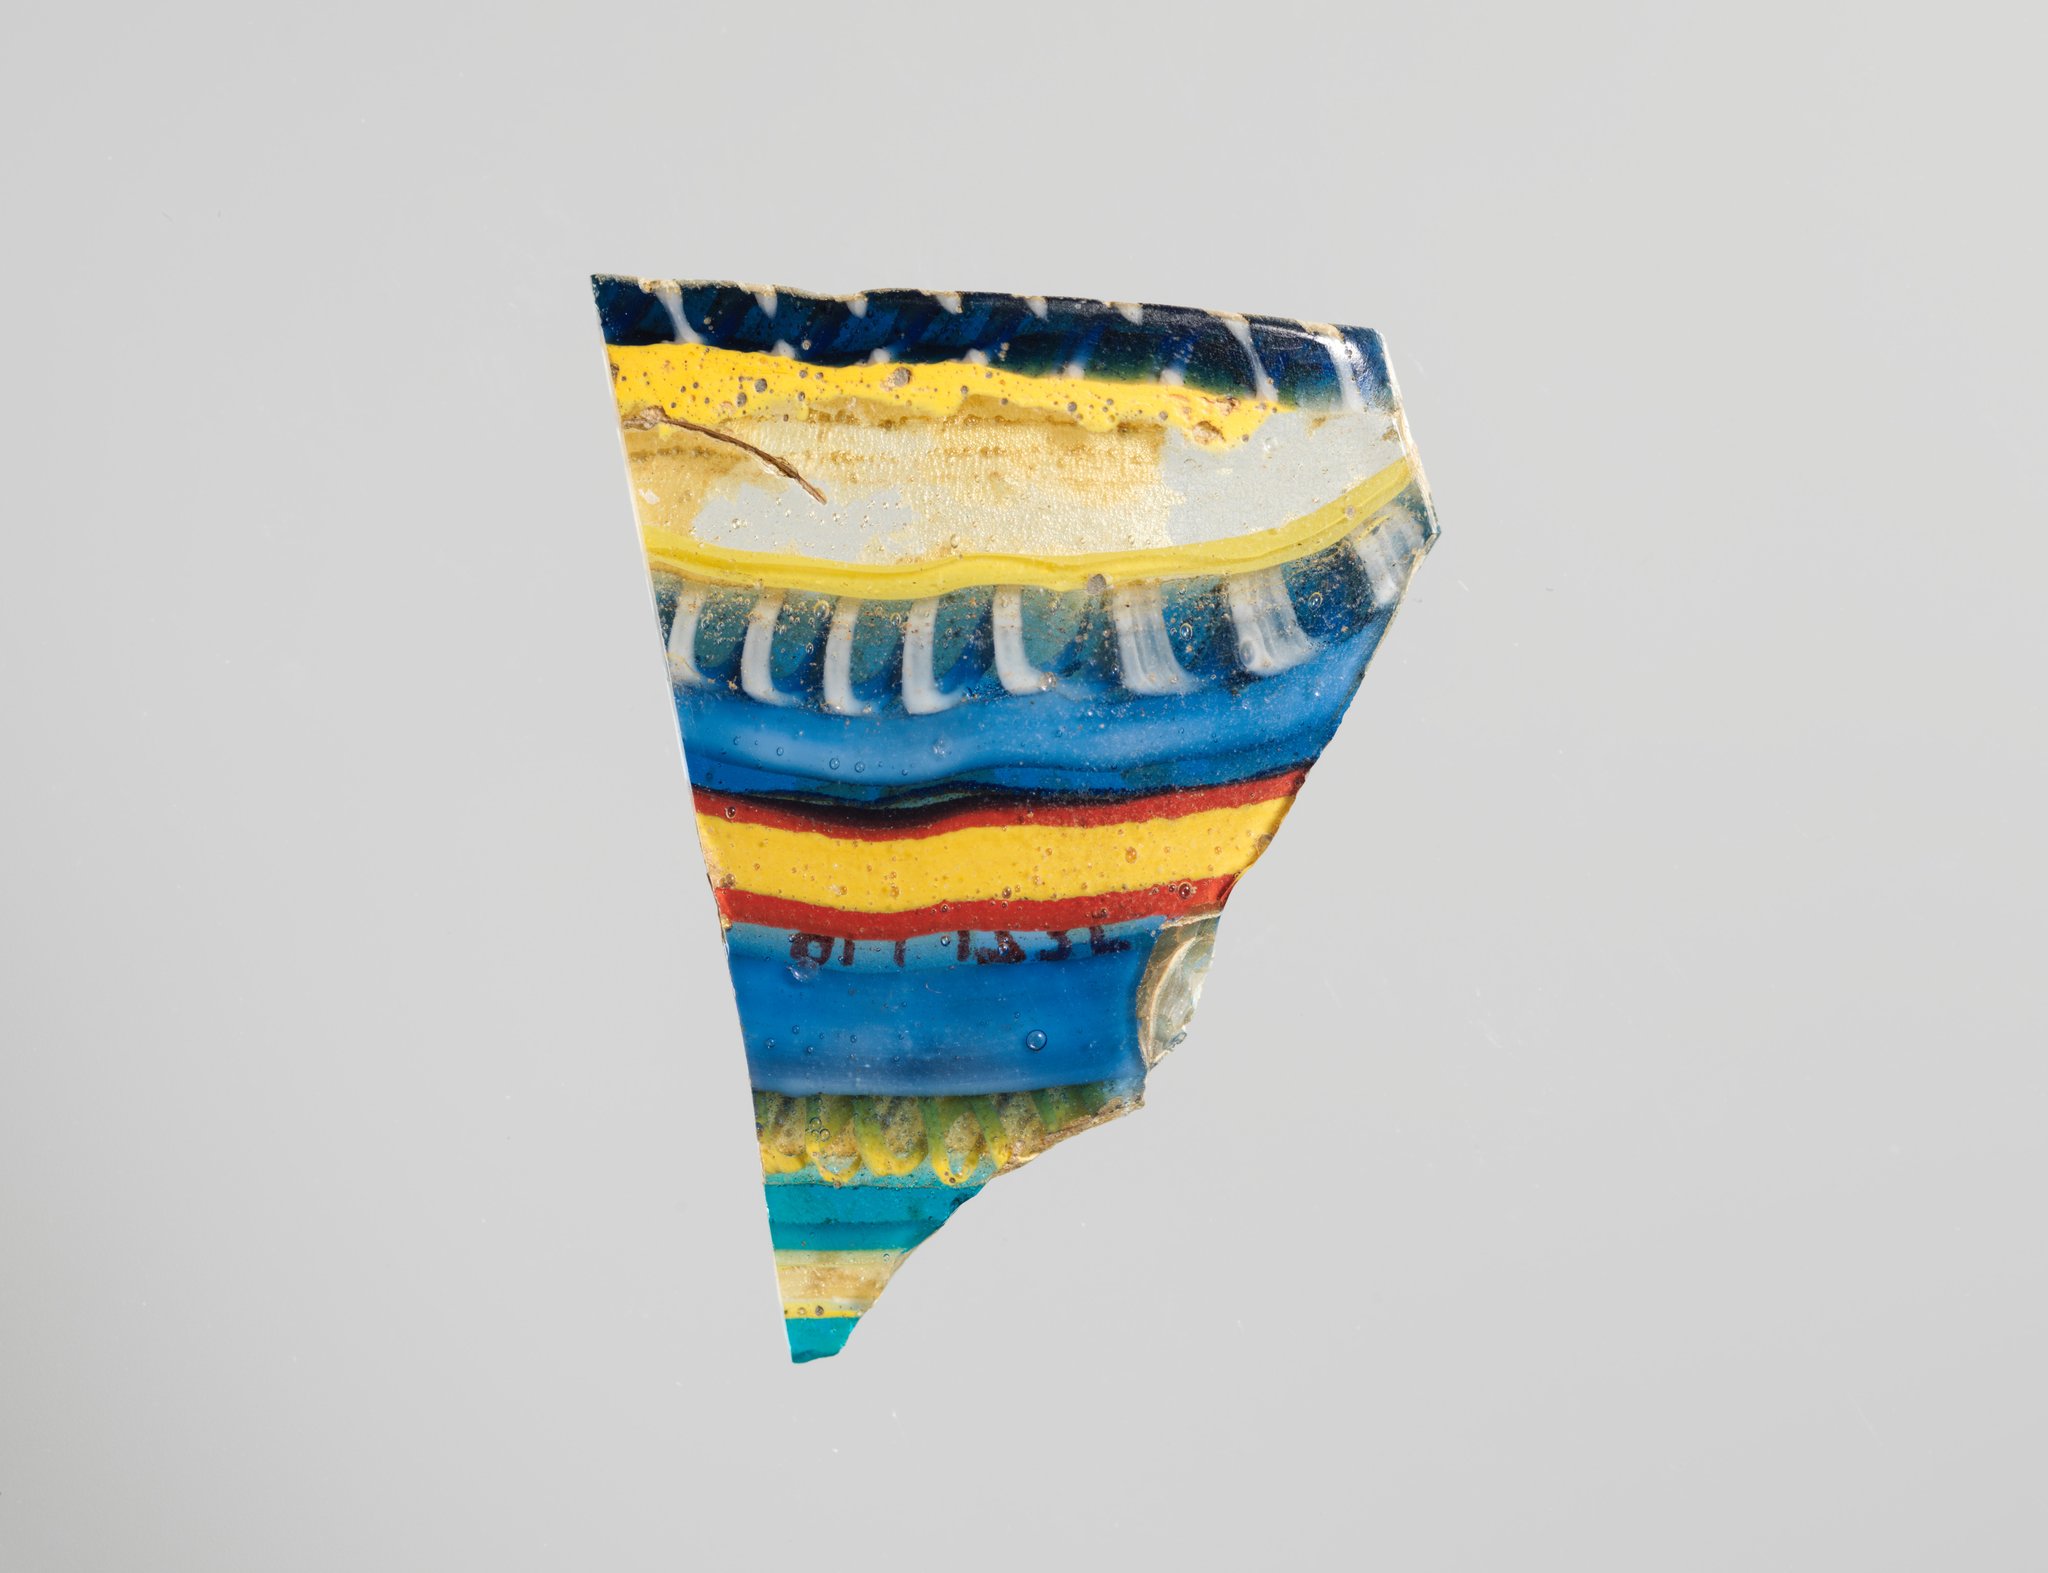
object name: fragment, striped mosaic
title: Glass striped mosaic bowl fragment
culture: roman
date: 34 BCE-33 CE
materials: glass